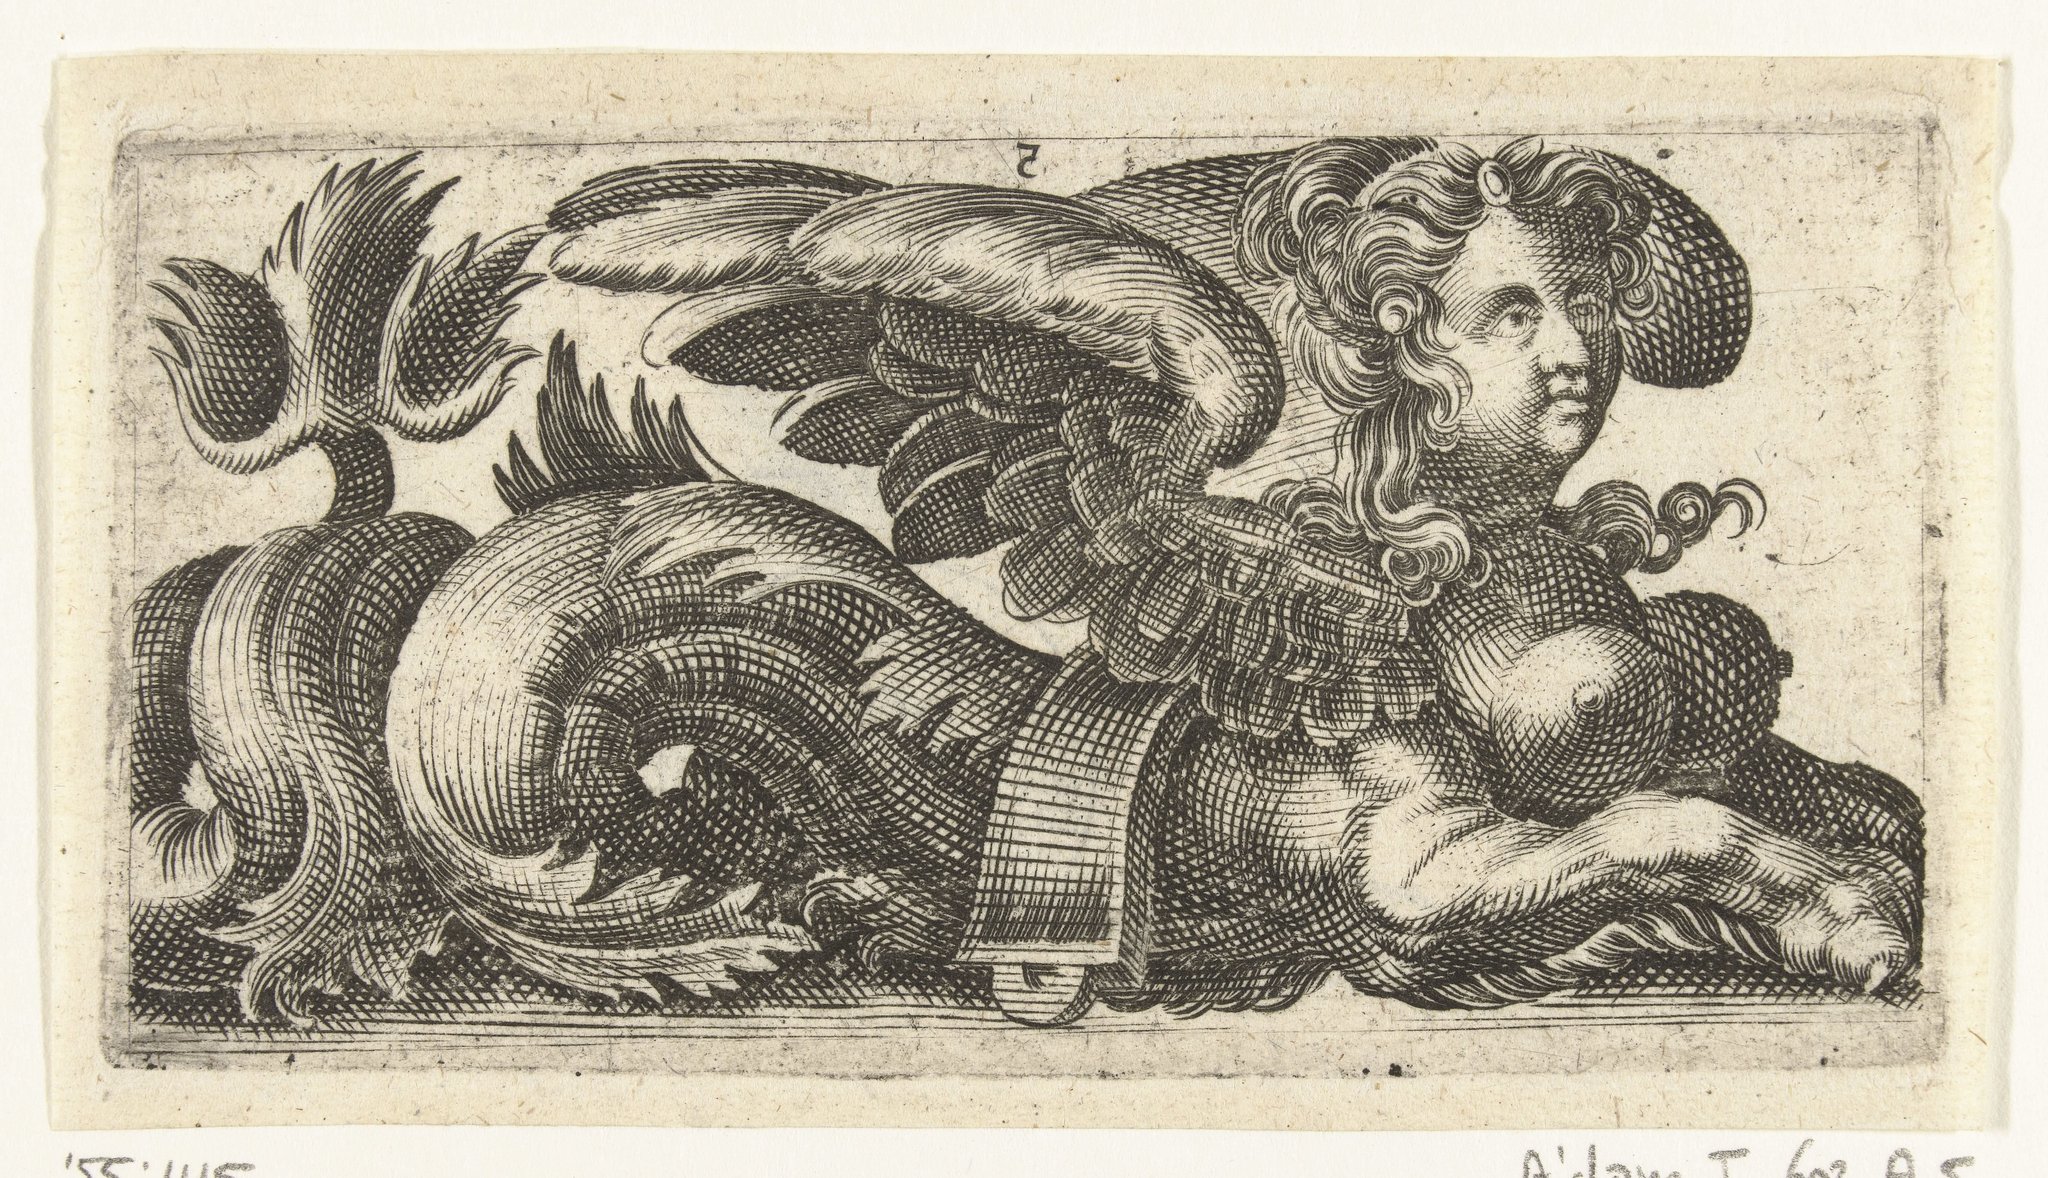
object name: ornament print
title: Friezen met zeemonsters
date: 1526-1606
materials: paper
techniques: engraving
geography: germany